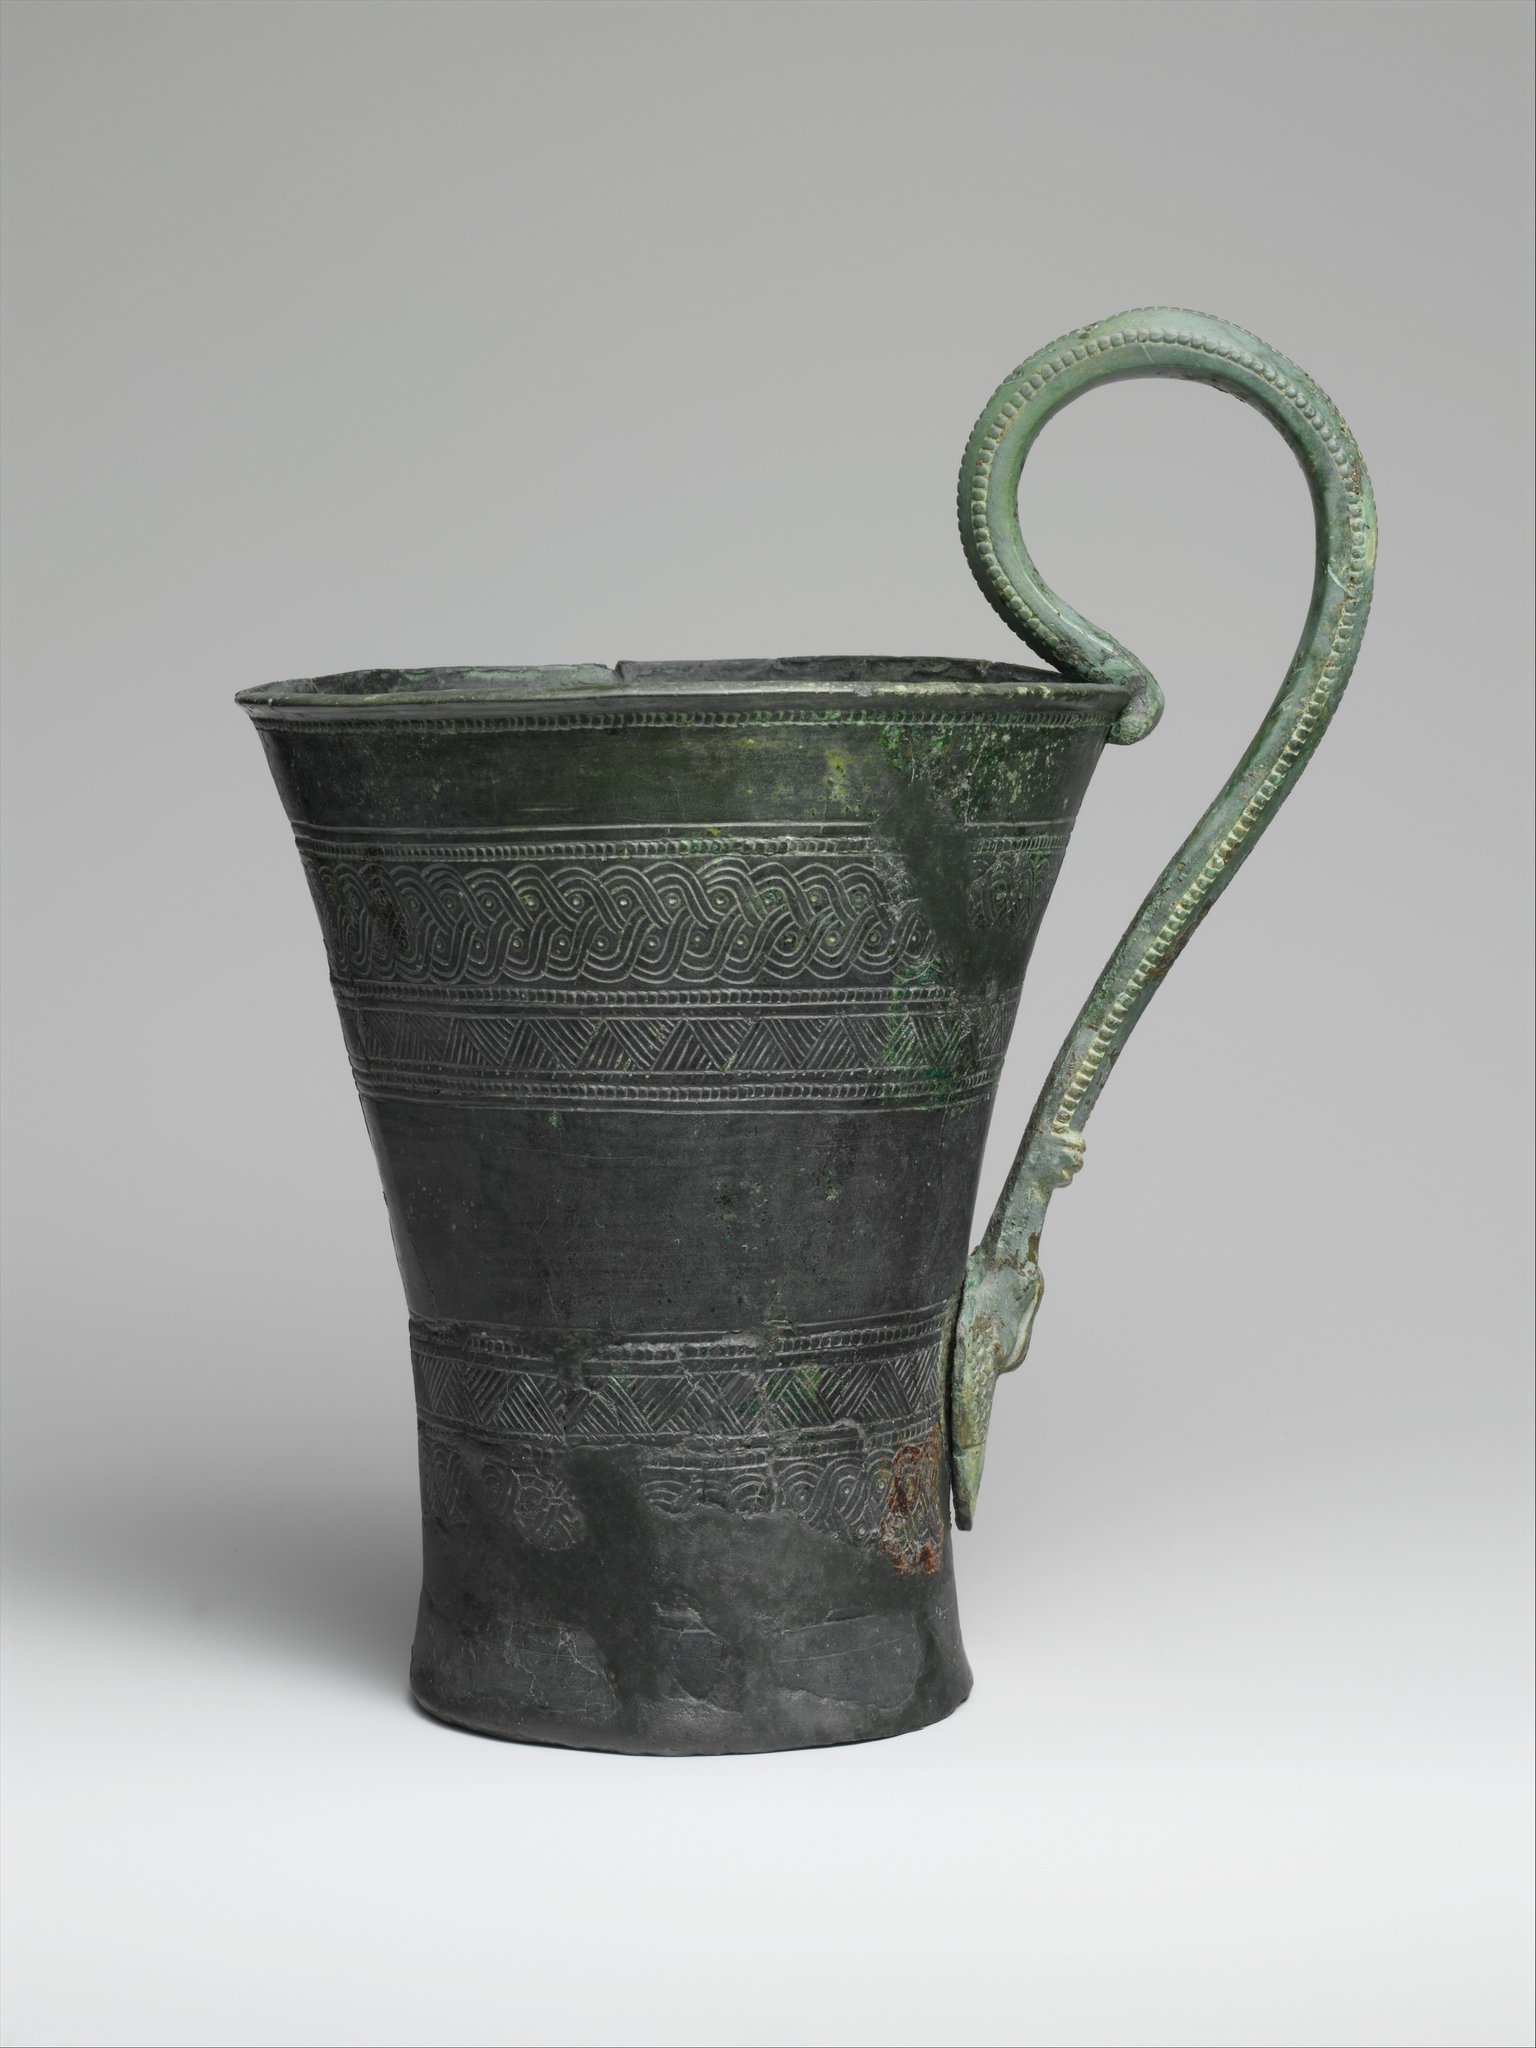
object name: kyathos ladle with bronze handle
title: Silver kyathos (ladle) with bronze handle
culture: etruscan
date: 400 BCE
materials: bronze, silver